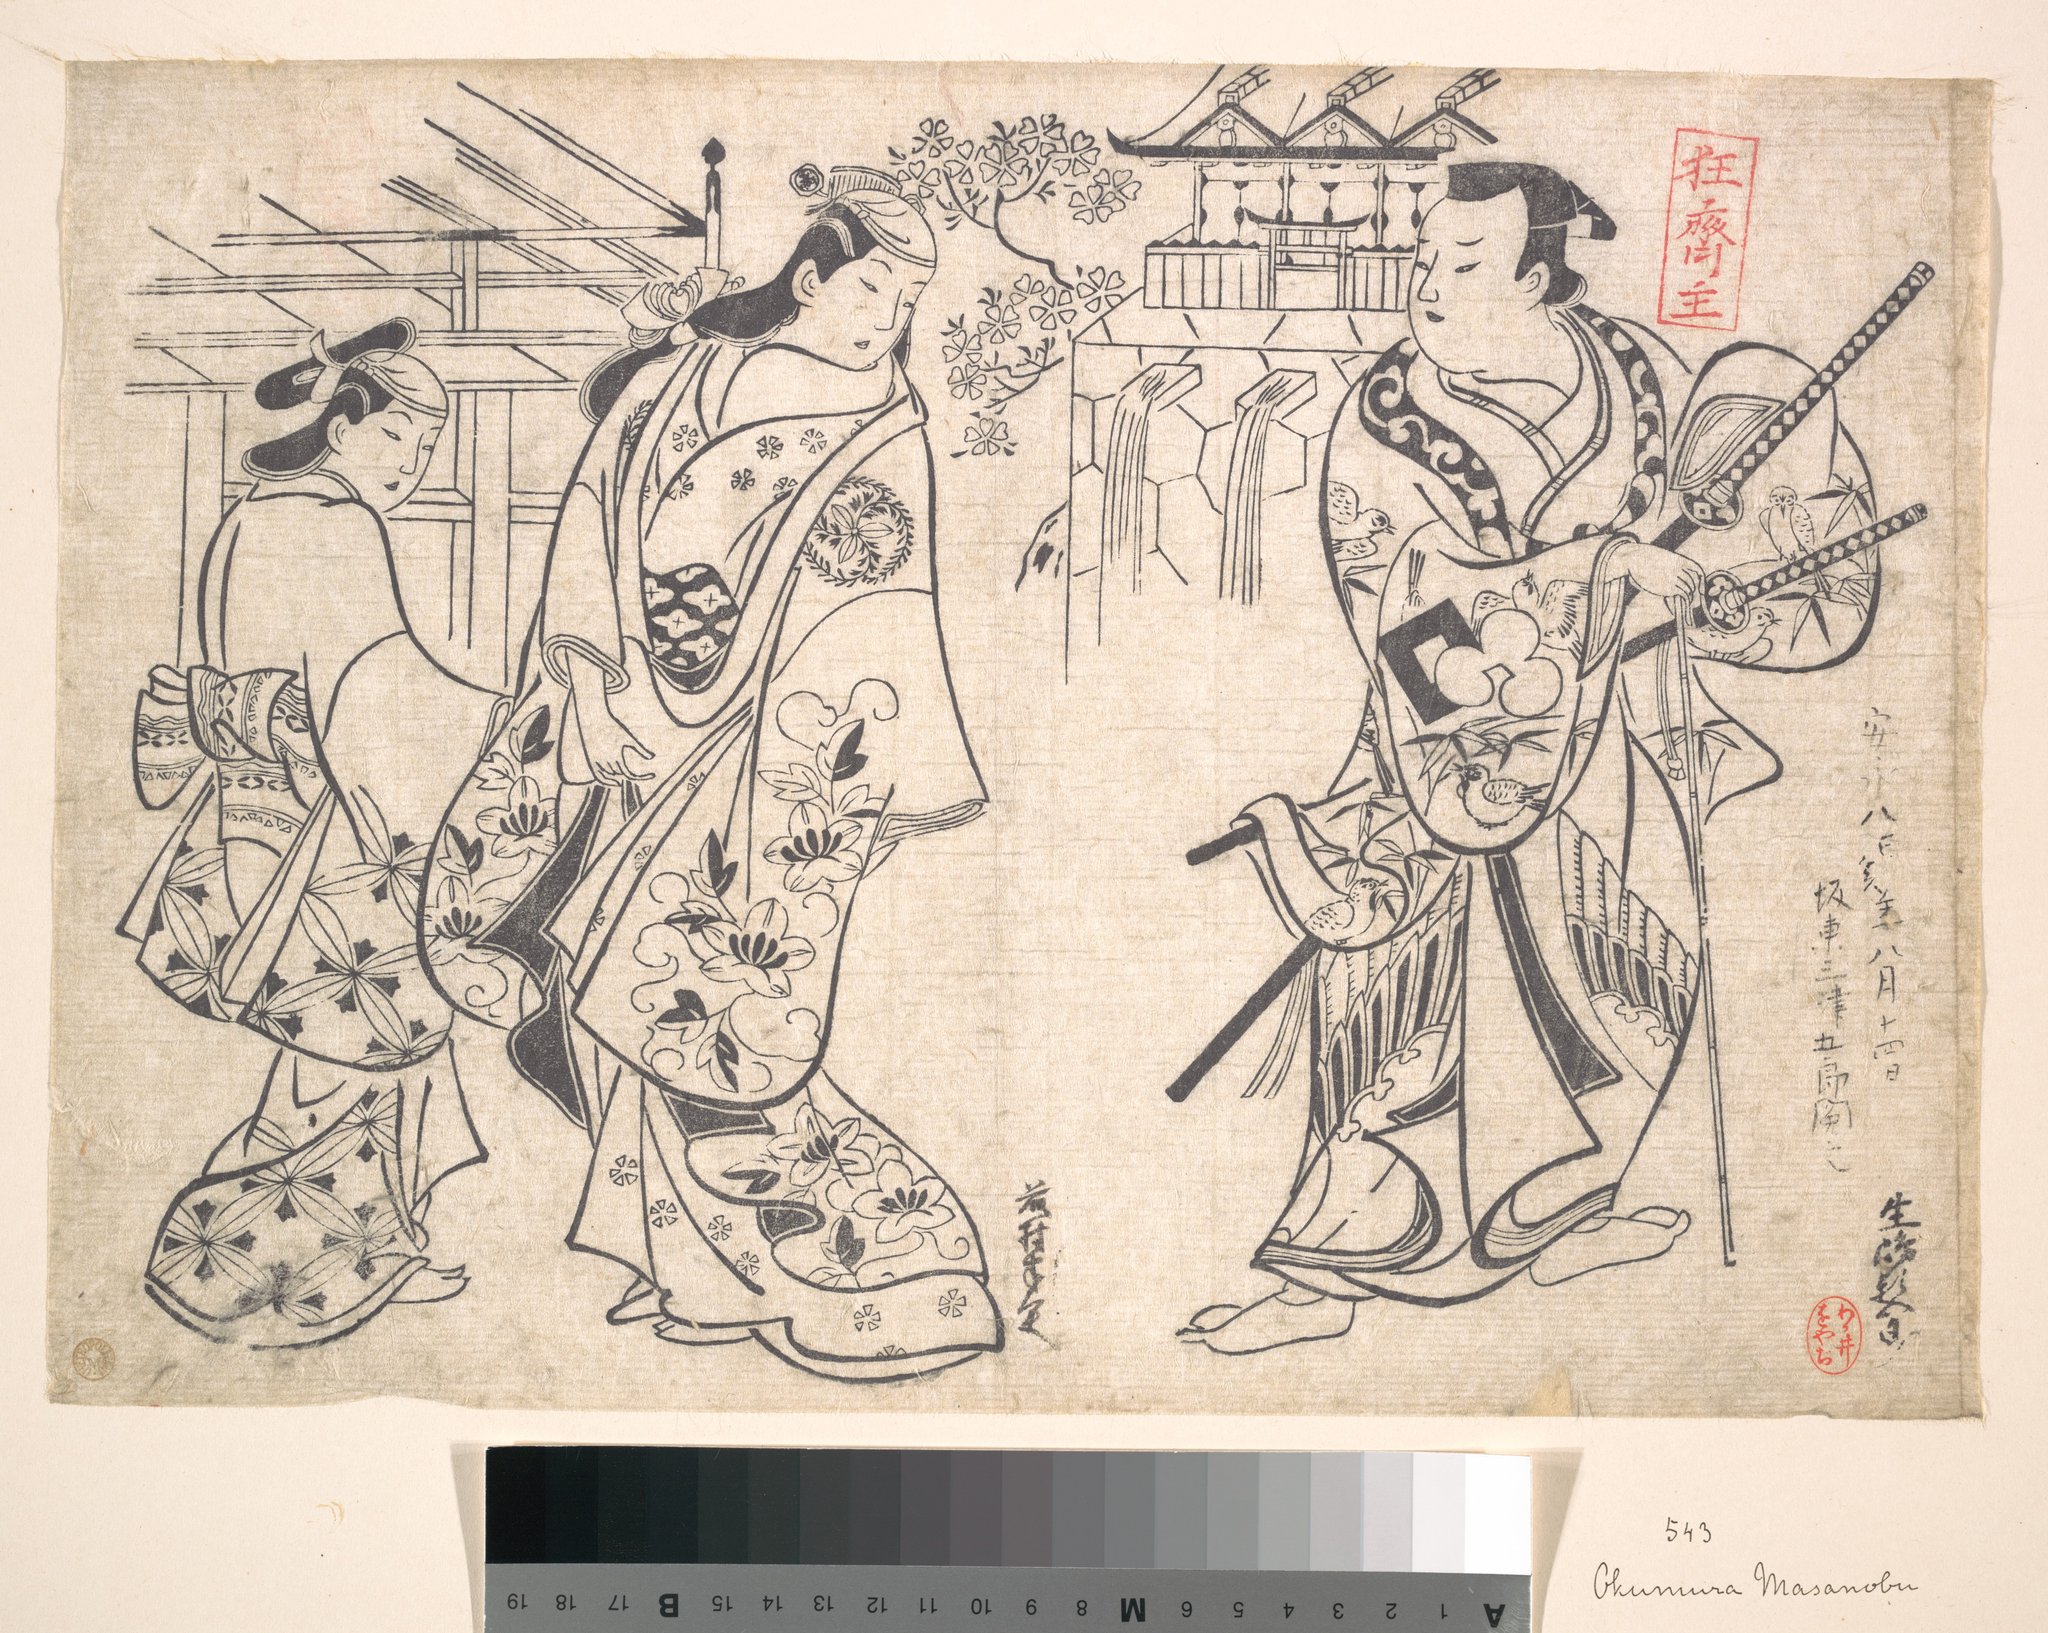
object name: print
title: Ikushima Shingoro as a Bushi (Samurai) and Ogino Yaegiri as a Woman with A girl Attendant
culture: japanese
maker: okumura masanobu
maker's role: artist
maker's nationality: japanese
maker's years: 1686-1764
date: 1709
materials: ink, paper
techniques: woodblock print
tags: girls,men,actors